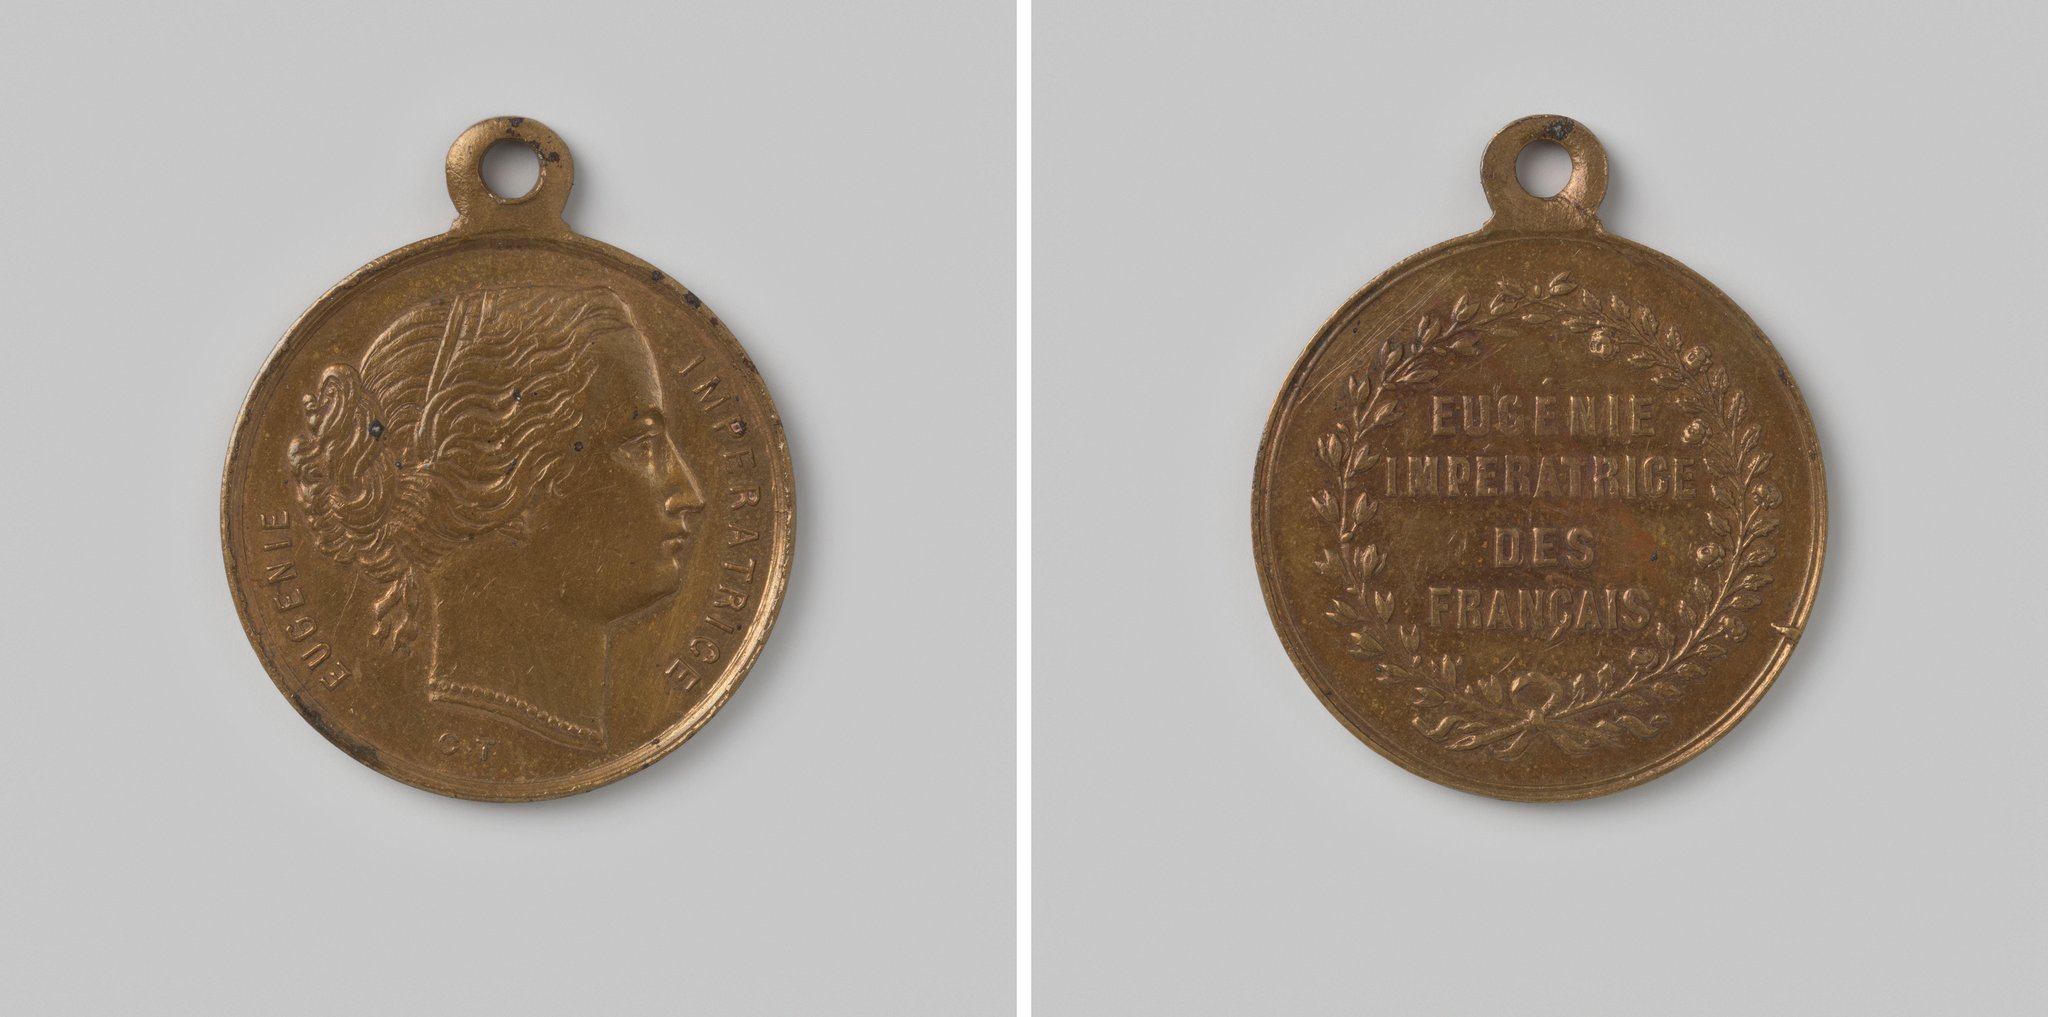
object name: history medal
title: Huwelijk van Napoleon III met Eugenia Maria de Guzman 1853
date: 1853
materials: brass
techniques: striking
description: Messing penning met draagoog, op de voorzijde het portret van Keizerin Eugenie naar rechts met omschrift, op de keerzijde vier regels tekst tussen samengestrikte lauwertakken.